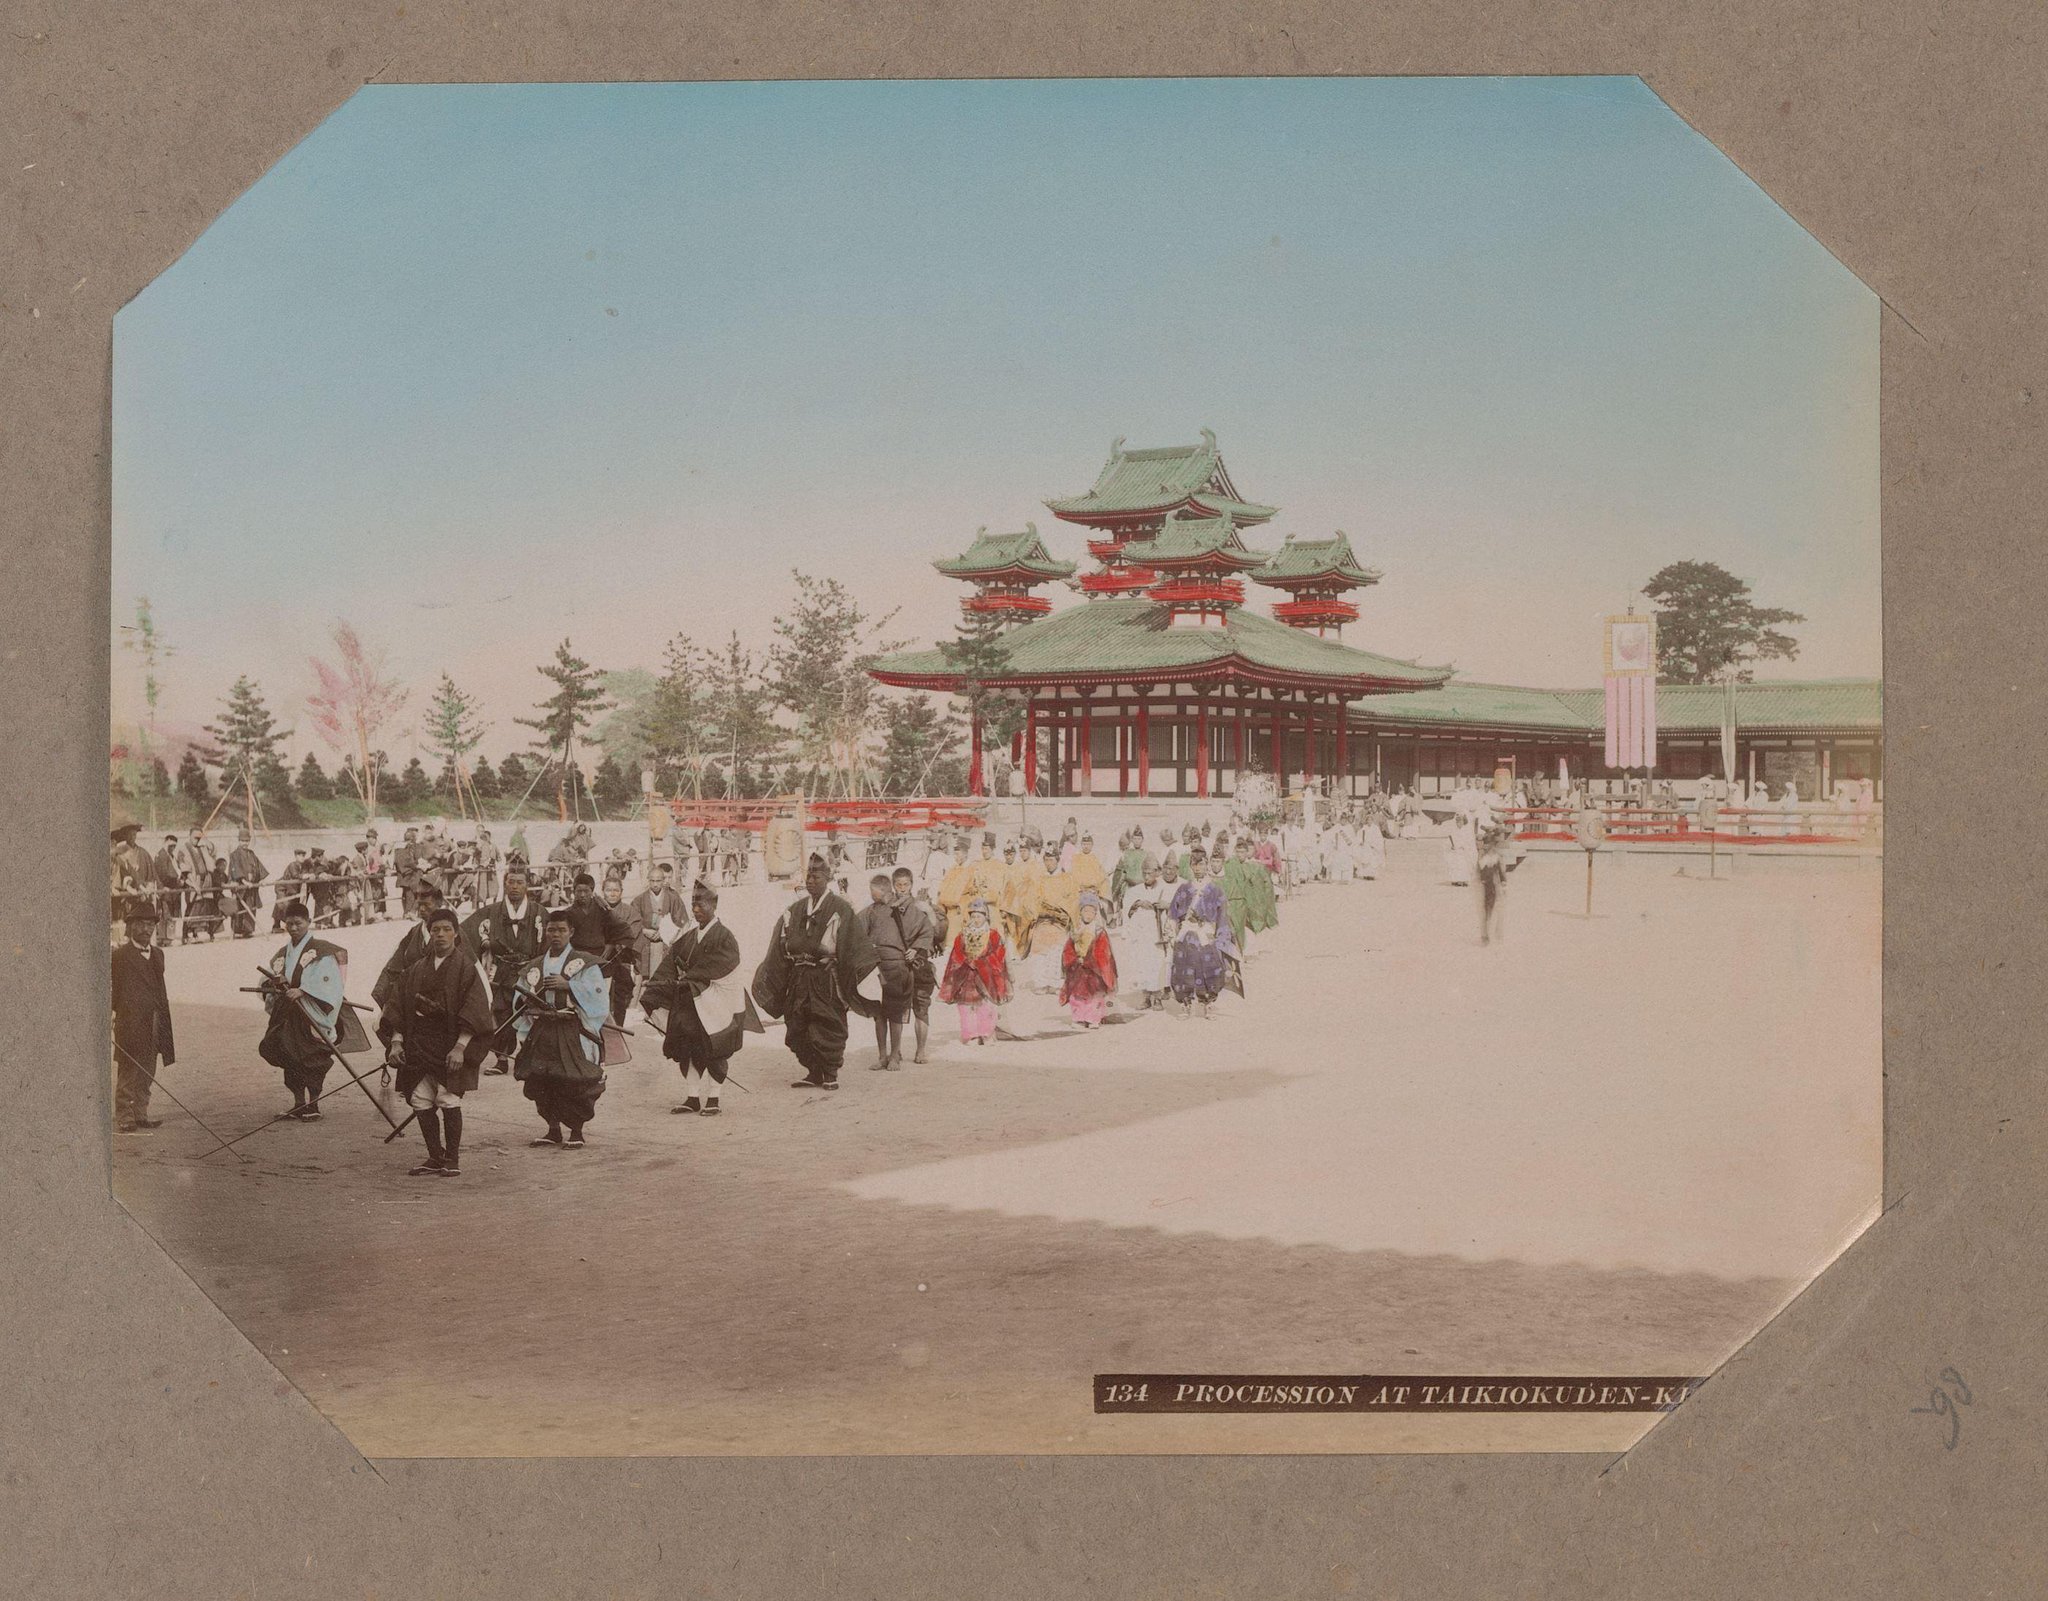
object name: album leaf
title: Processie bij de Tai-kioku Den tempel in Kyoto, Japan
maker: Anonymous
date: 1890-1903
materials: paper, photographic support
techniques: albumen print, hand coloring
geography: kyoto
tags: temple, shrine ~ shinto, public festivities (+ parade, pageant, cavalcade ~ festive activities), kyoto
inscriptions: inscription: ‘134 Procession at Taikiokuden-Kioto’